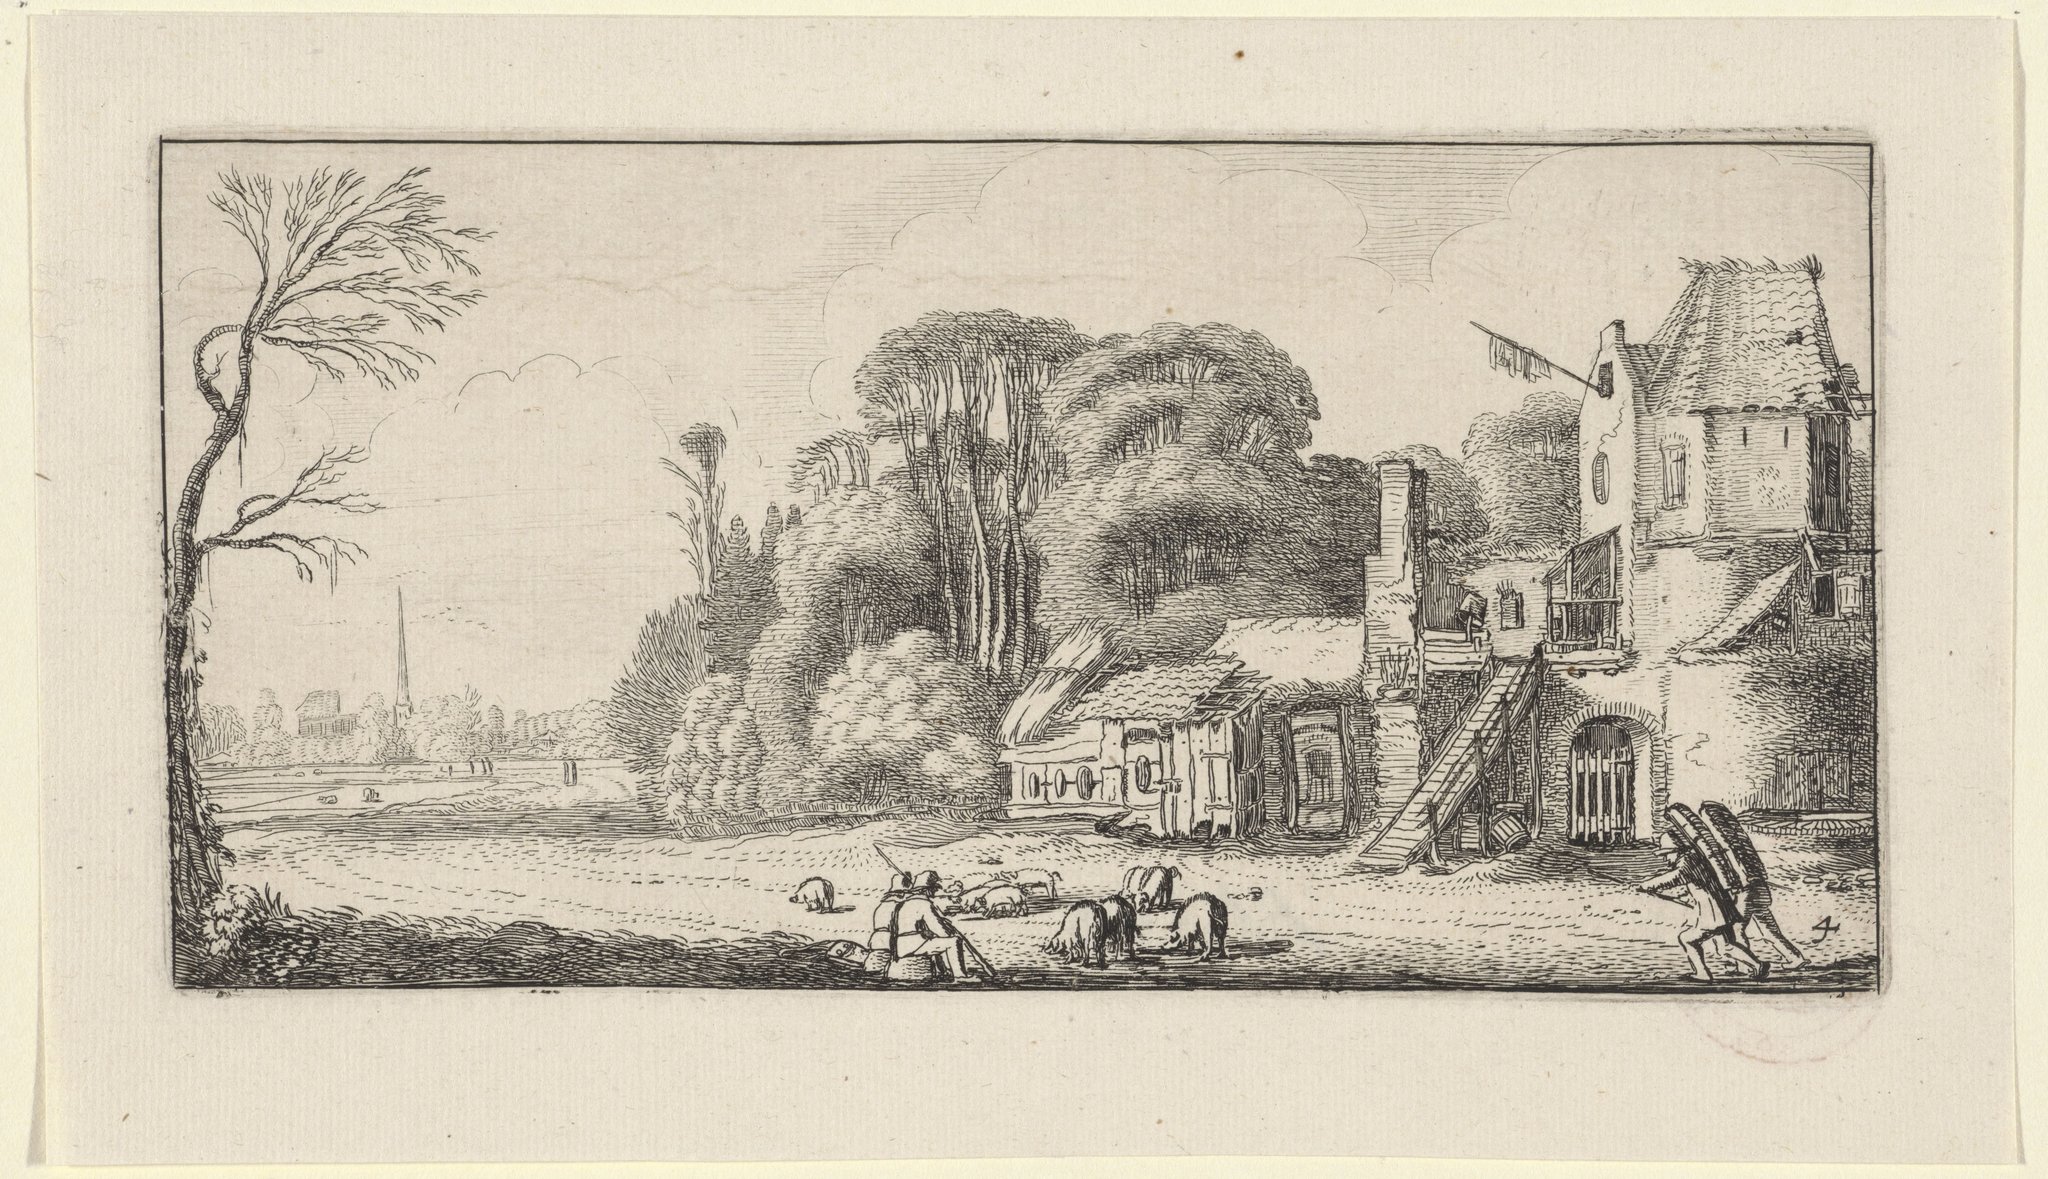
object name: print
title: Landschap met varkens en marskramers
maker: jan van de velde (ii)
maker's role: draughtsman, painter, print maker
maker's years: 1593-1641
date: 1603-1641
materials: paper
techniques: etching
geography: northern netherlands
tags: city-view, and landscape with man-made constructions, pig, pedlar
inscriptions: collector's mark: Lugt 240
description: Landschap met varkens en varkenshoeders bij een huis. Rechts twee marskramers. Vierde prent uit een serie van zes.